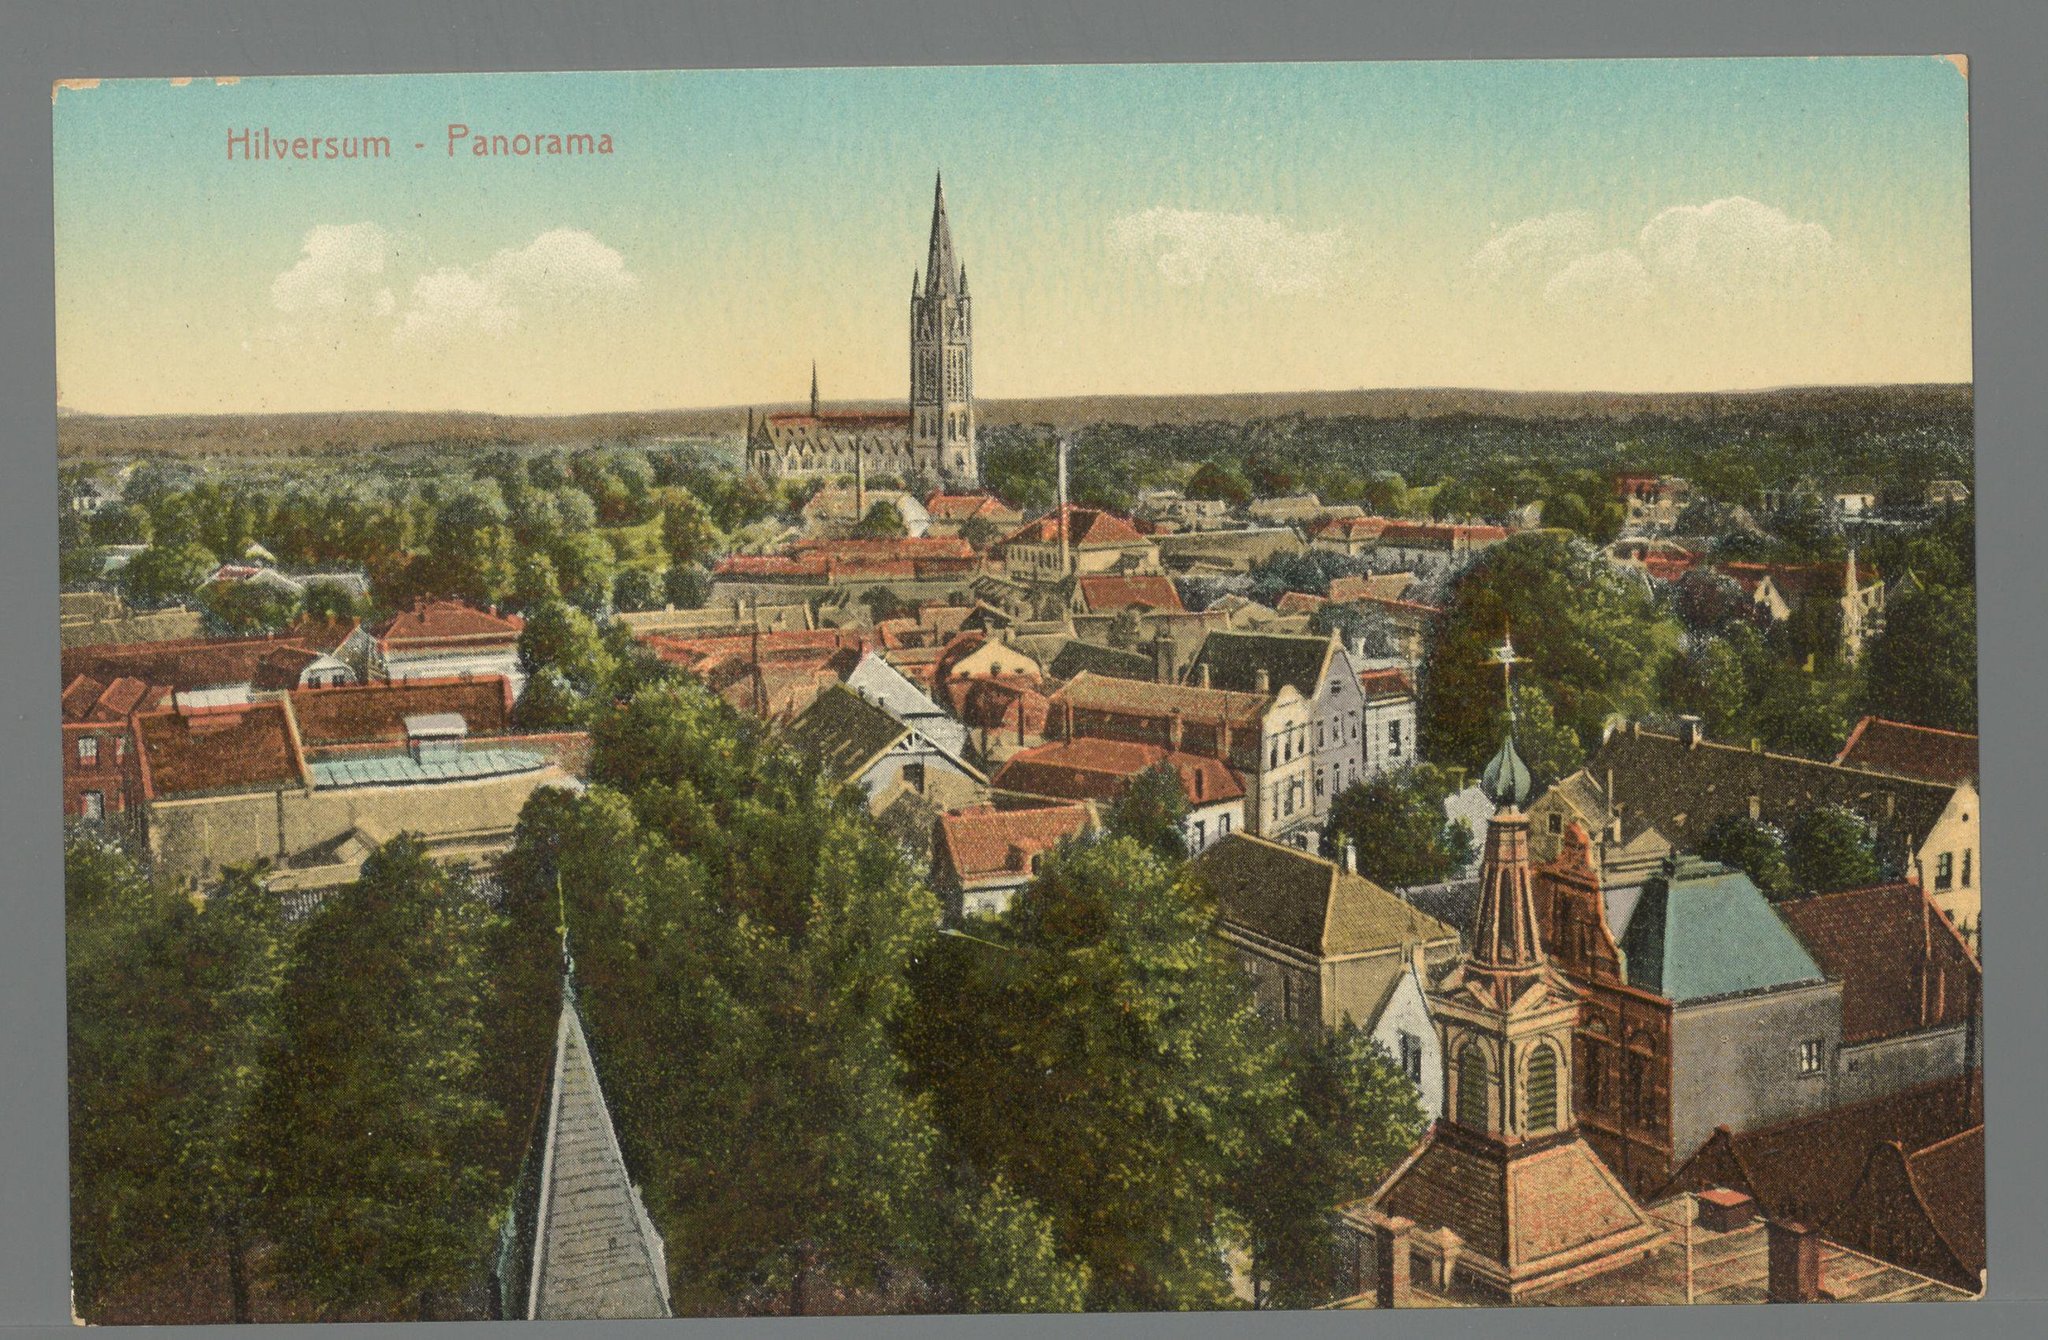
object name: photomechanical print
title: J.H. Schaefer's Edition Fotochrom.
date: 1905-1909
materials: cardboard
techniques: lithograph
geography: amsterdam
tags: city-view, and landscape with man-made constructions, church (exterior)